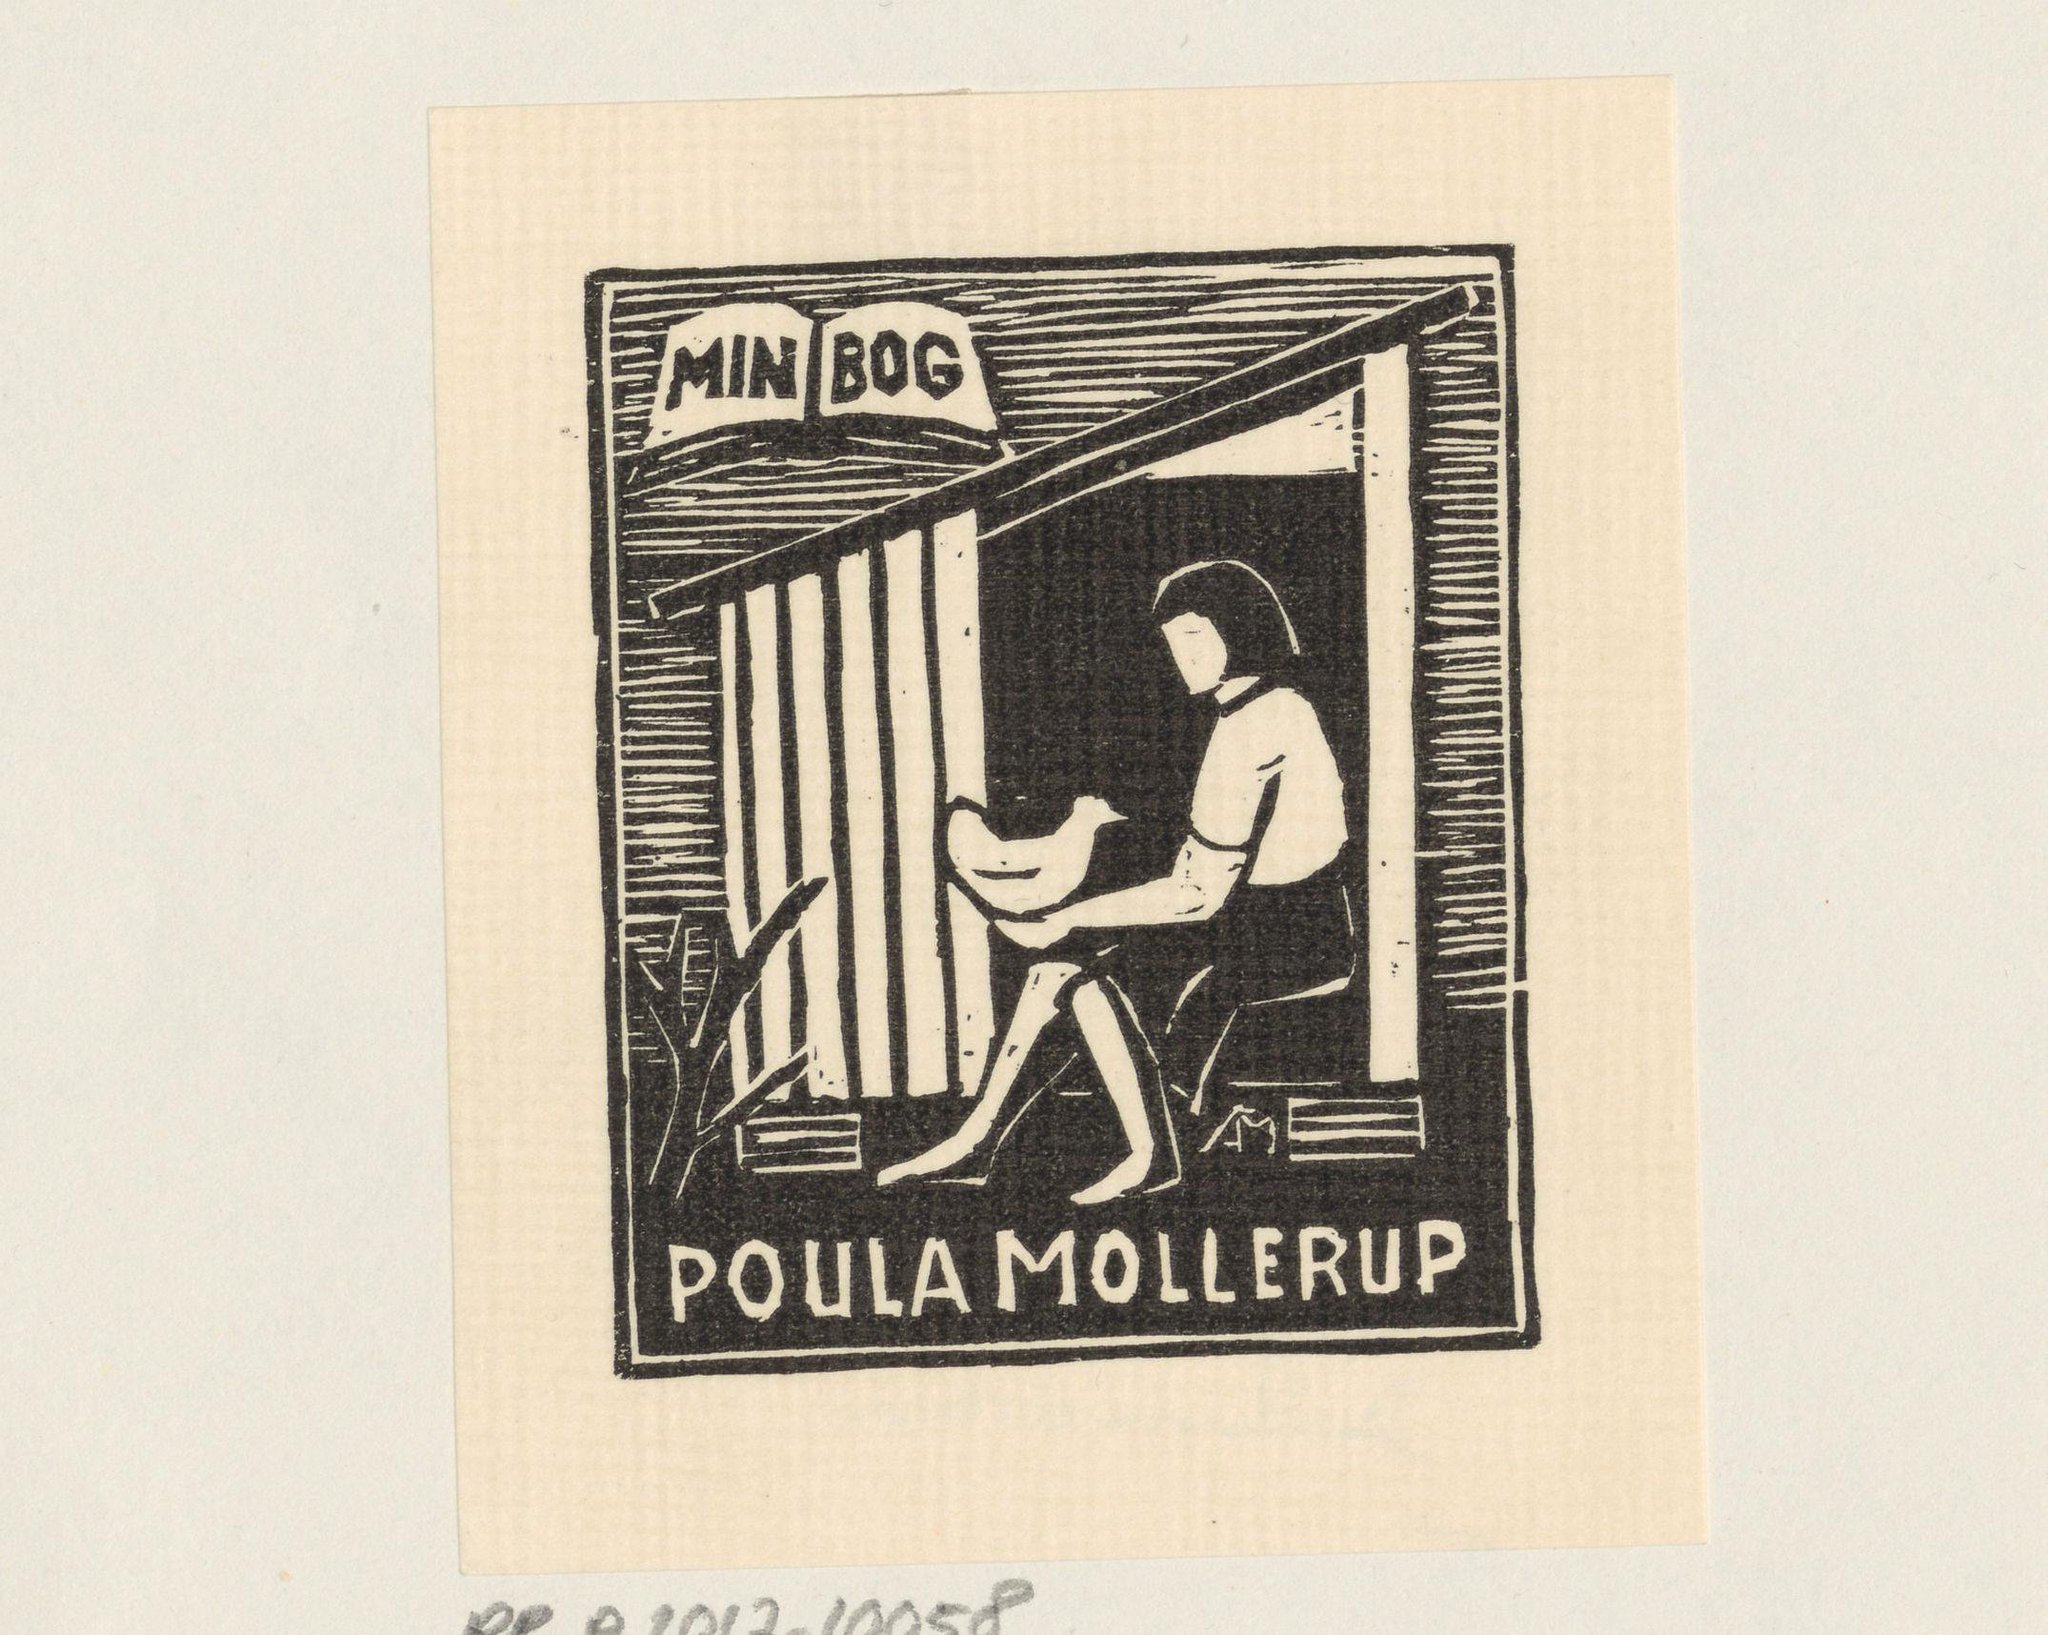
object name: bookplate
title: Ex libris van Poula Mollerup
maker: svend aage mollerup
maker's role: print maker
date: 1900-1999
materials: paper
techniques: woodcut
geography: denmark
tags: sitting figure - aa - female human figure, fowl (cock, hen, chicken, etc.), shed